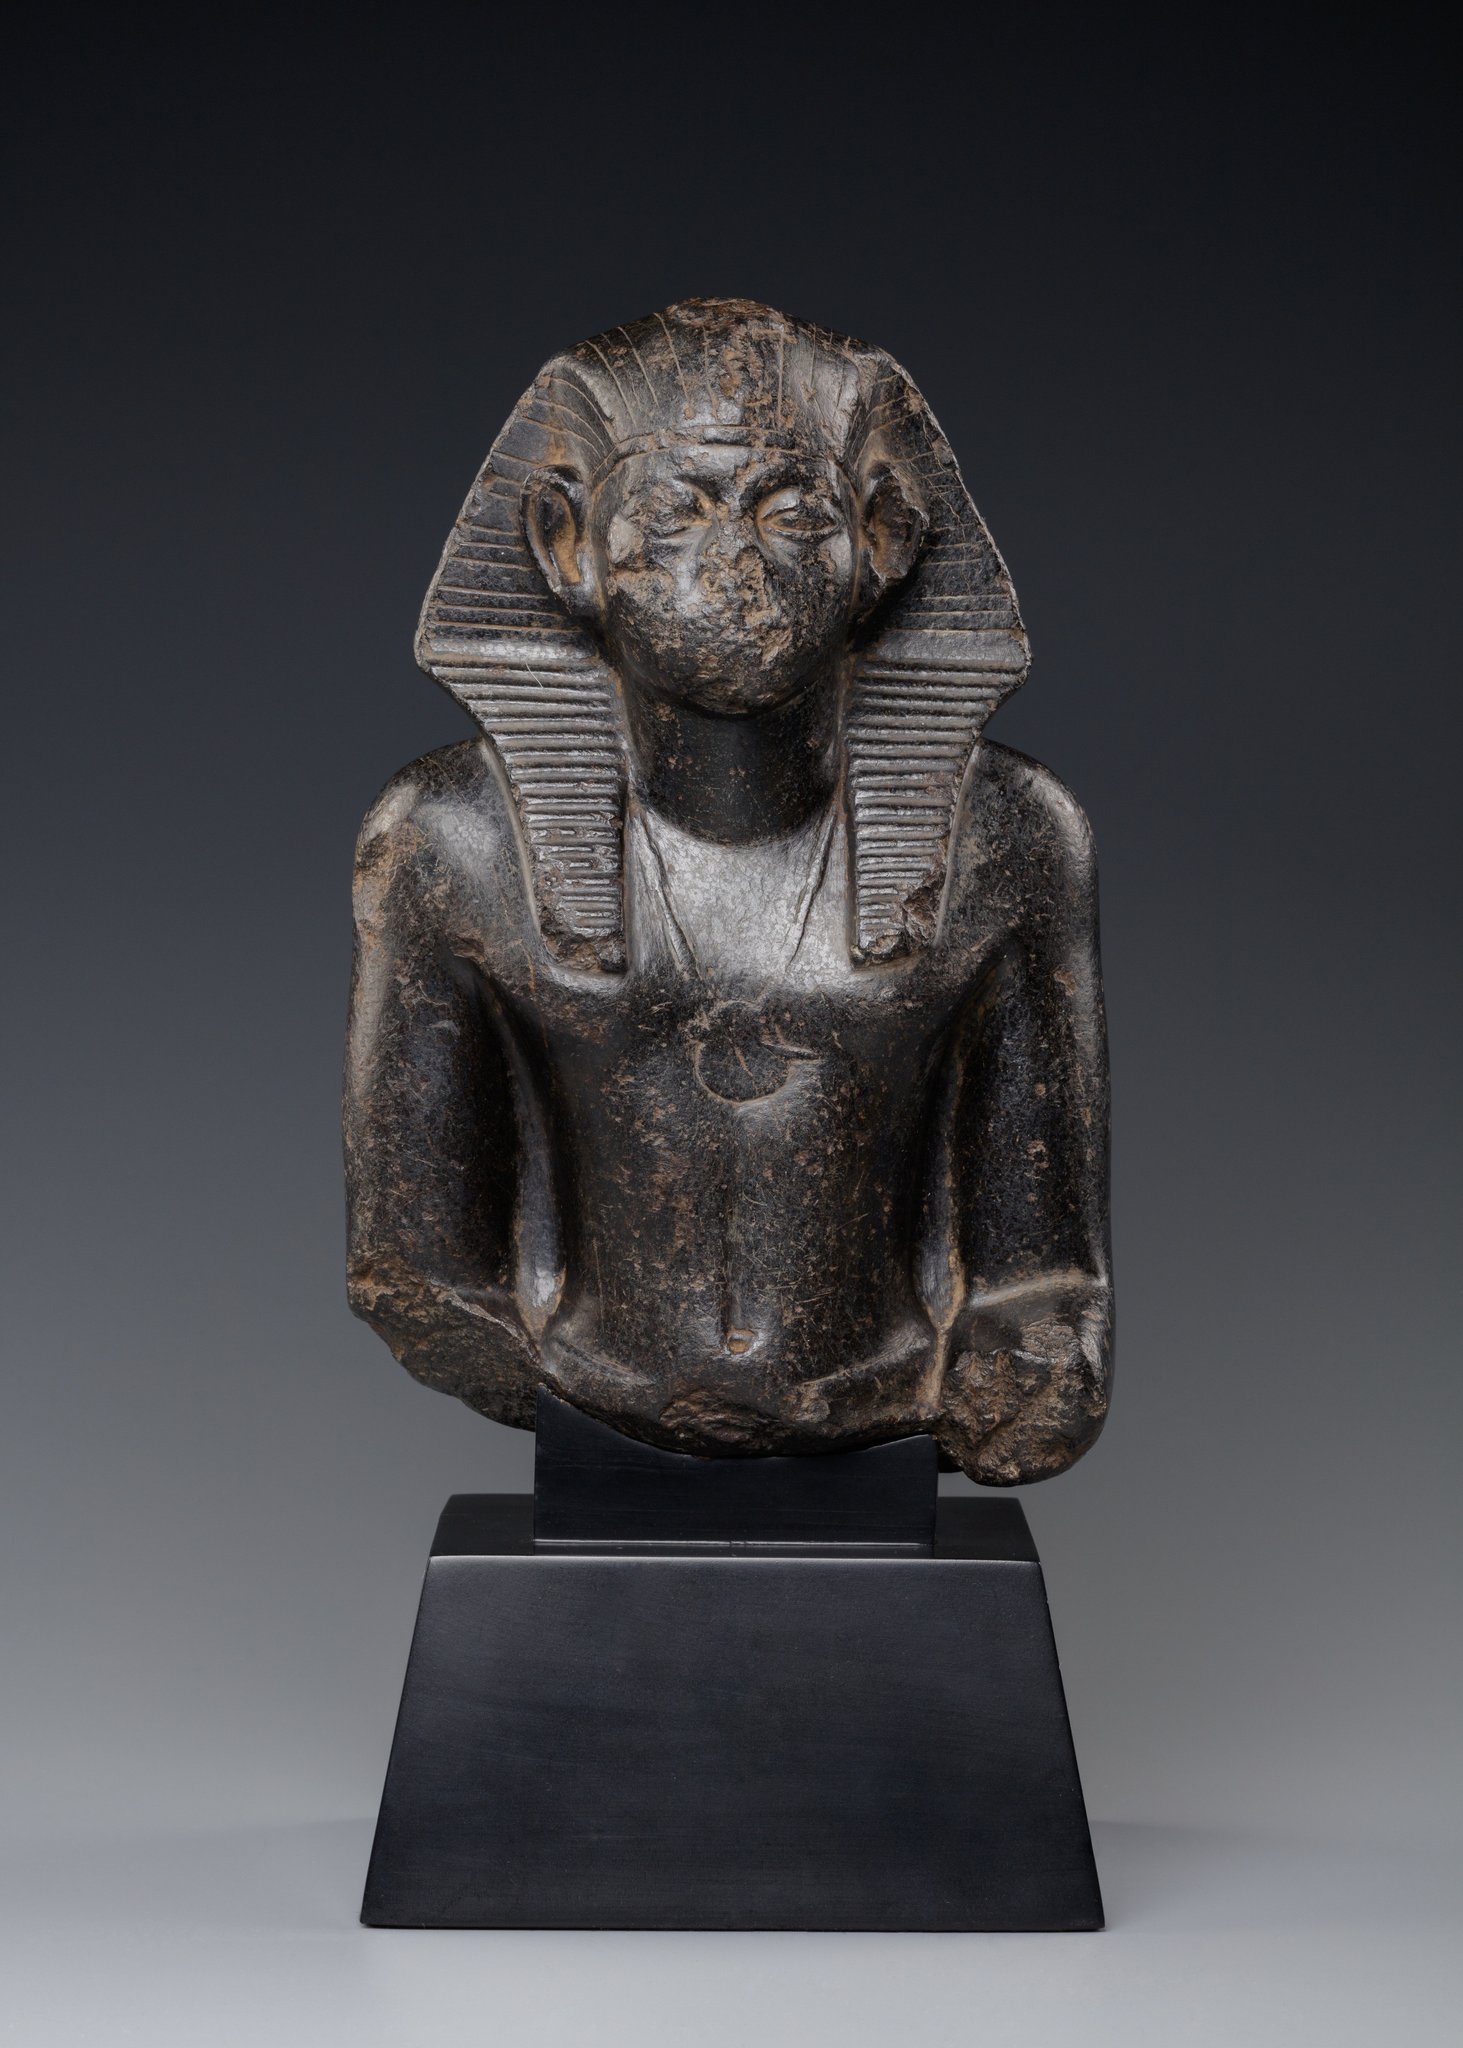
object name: upper part of a seated statue of pharaoh senwosret iii or amenemhat iii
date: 1878-1813 BCE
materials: stone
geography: egypt